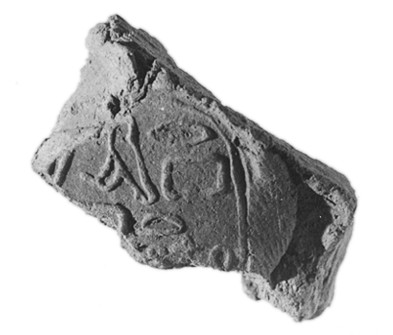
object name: sealing, private name and title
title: Sealing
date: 2030-1640 BCE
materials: clay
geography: egypt